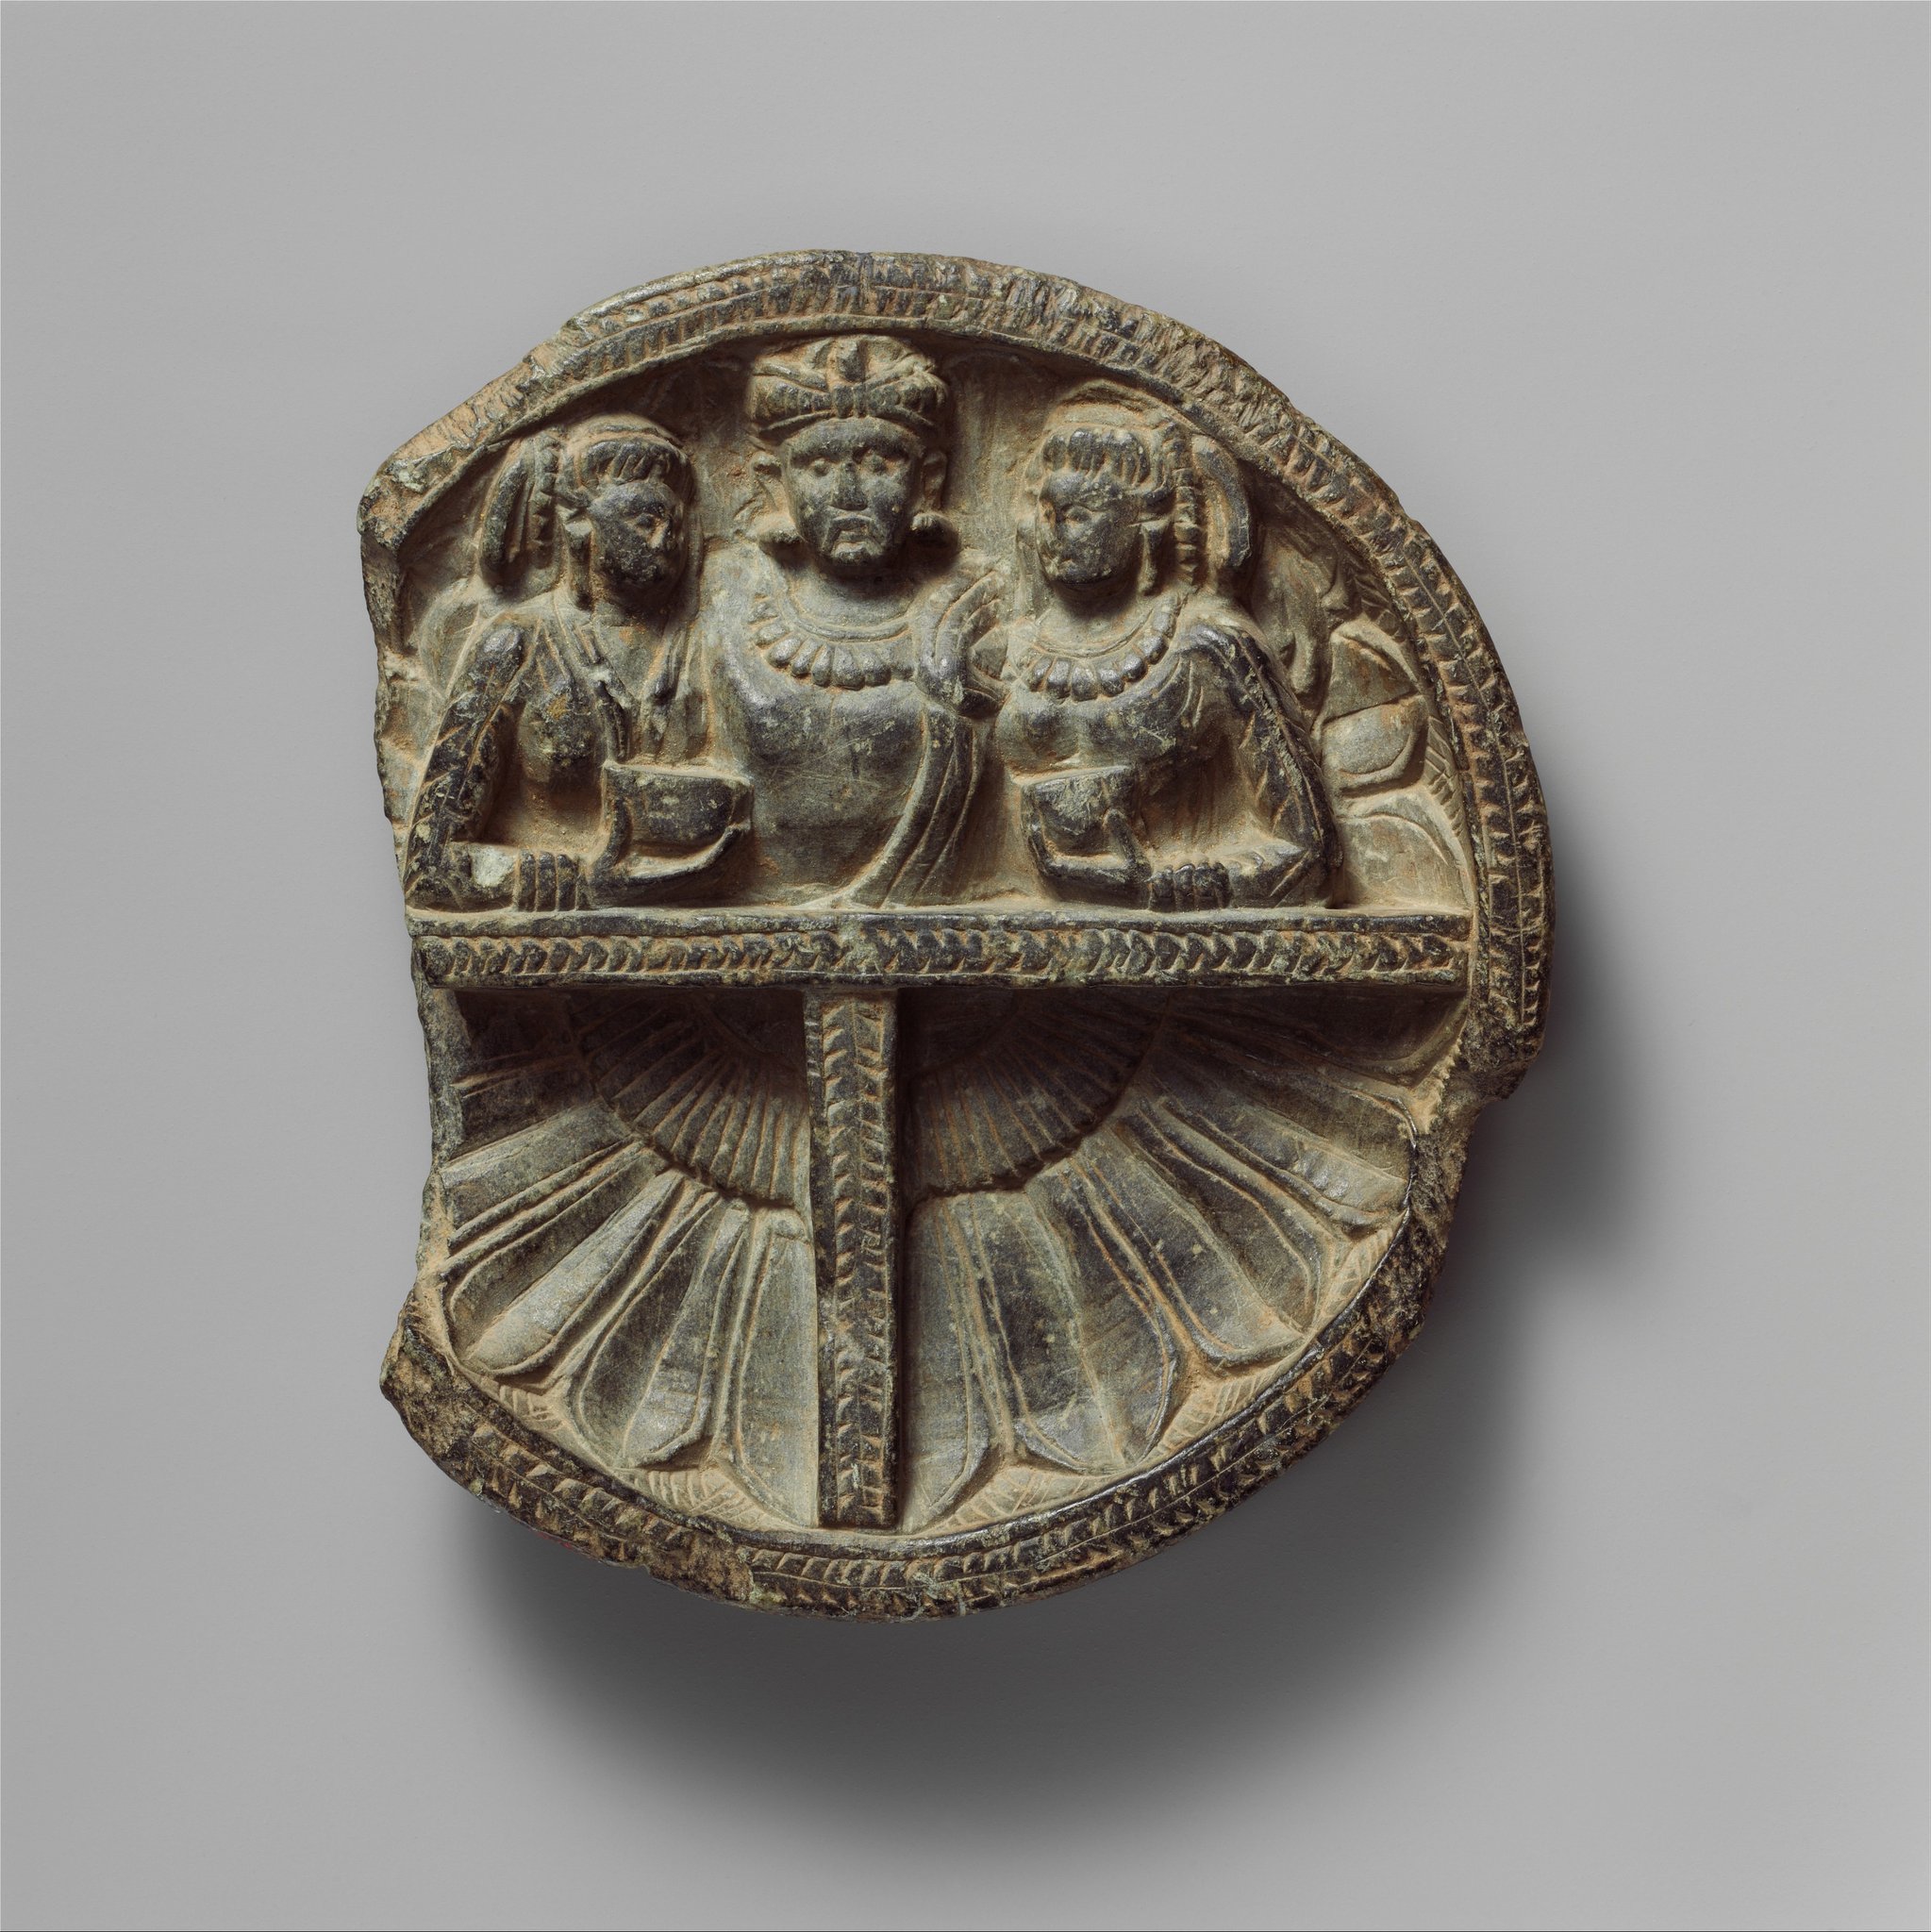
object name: dish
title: Dish with Drunken Herakles Embracing Two Women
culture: gandhara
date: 1-100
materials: stone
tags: gandhara,women,herakles